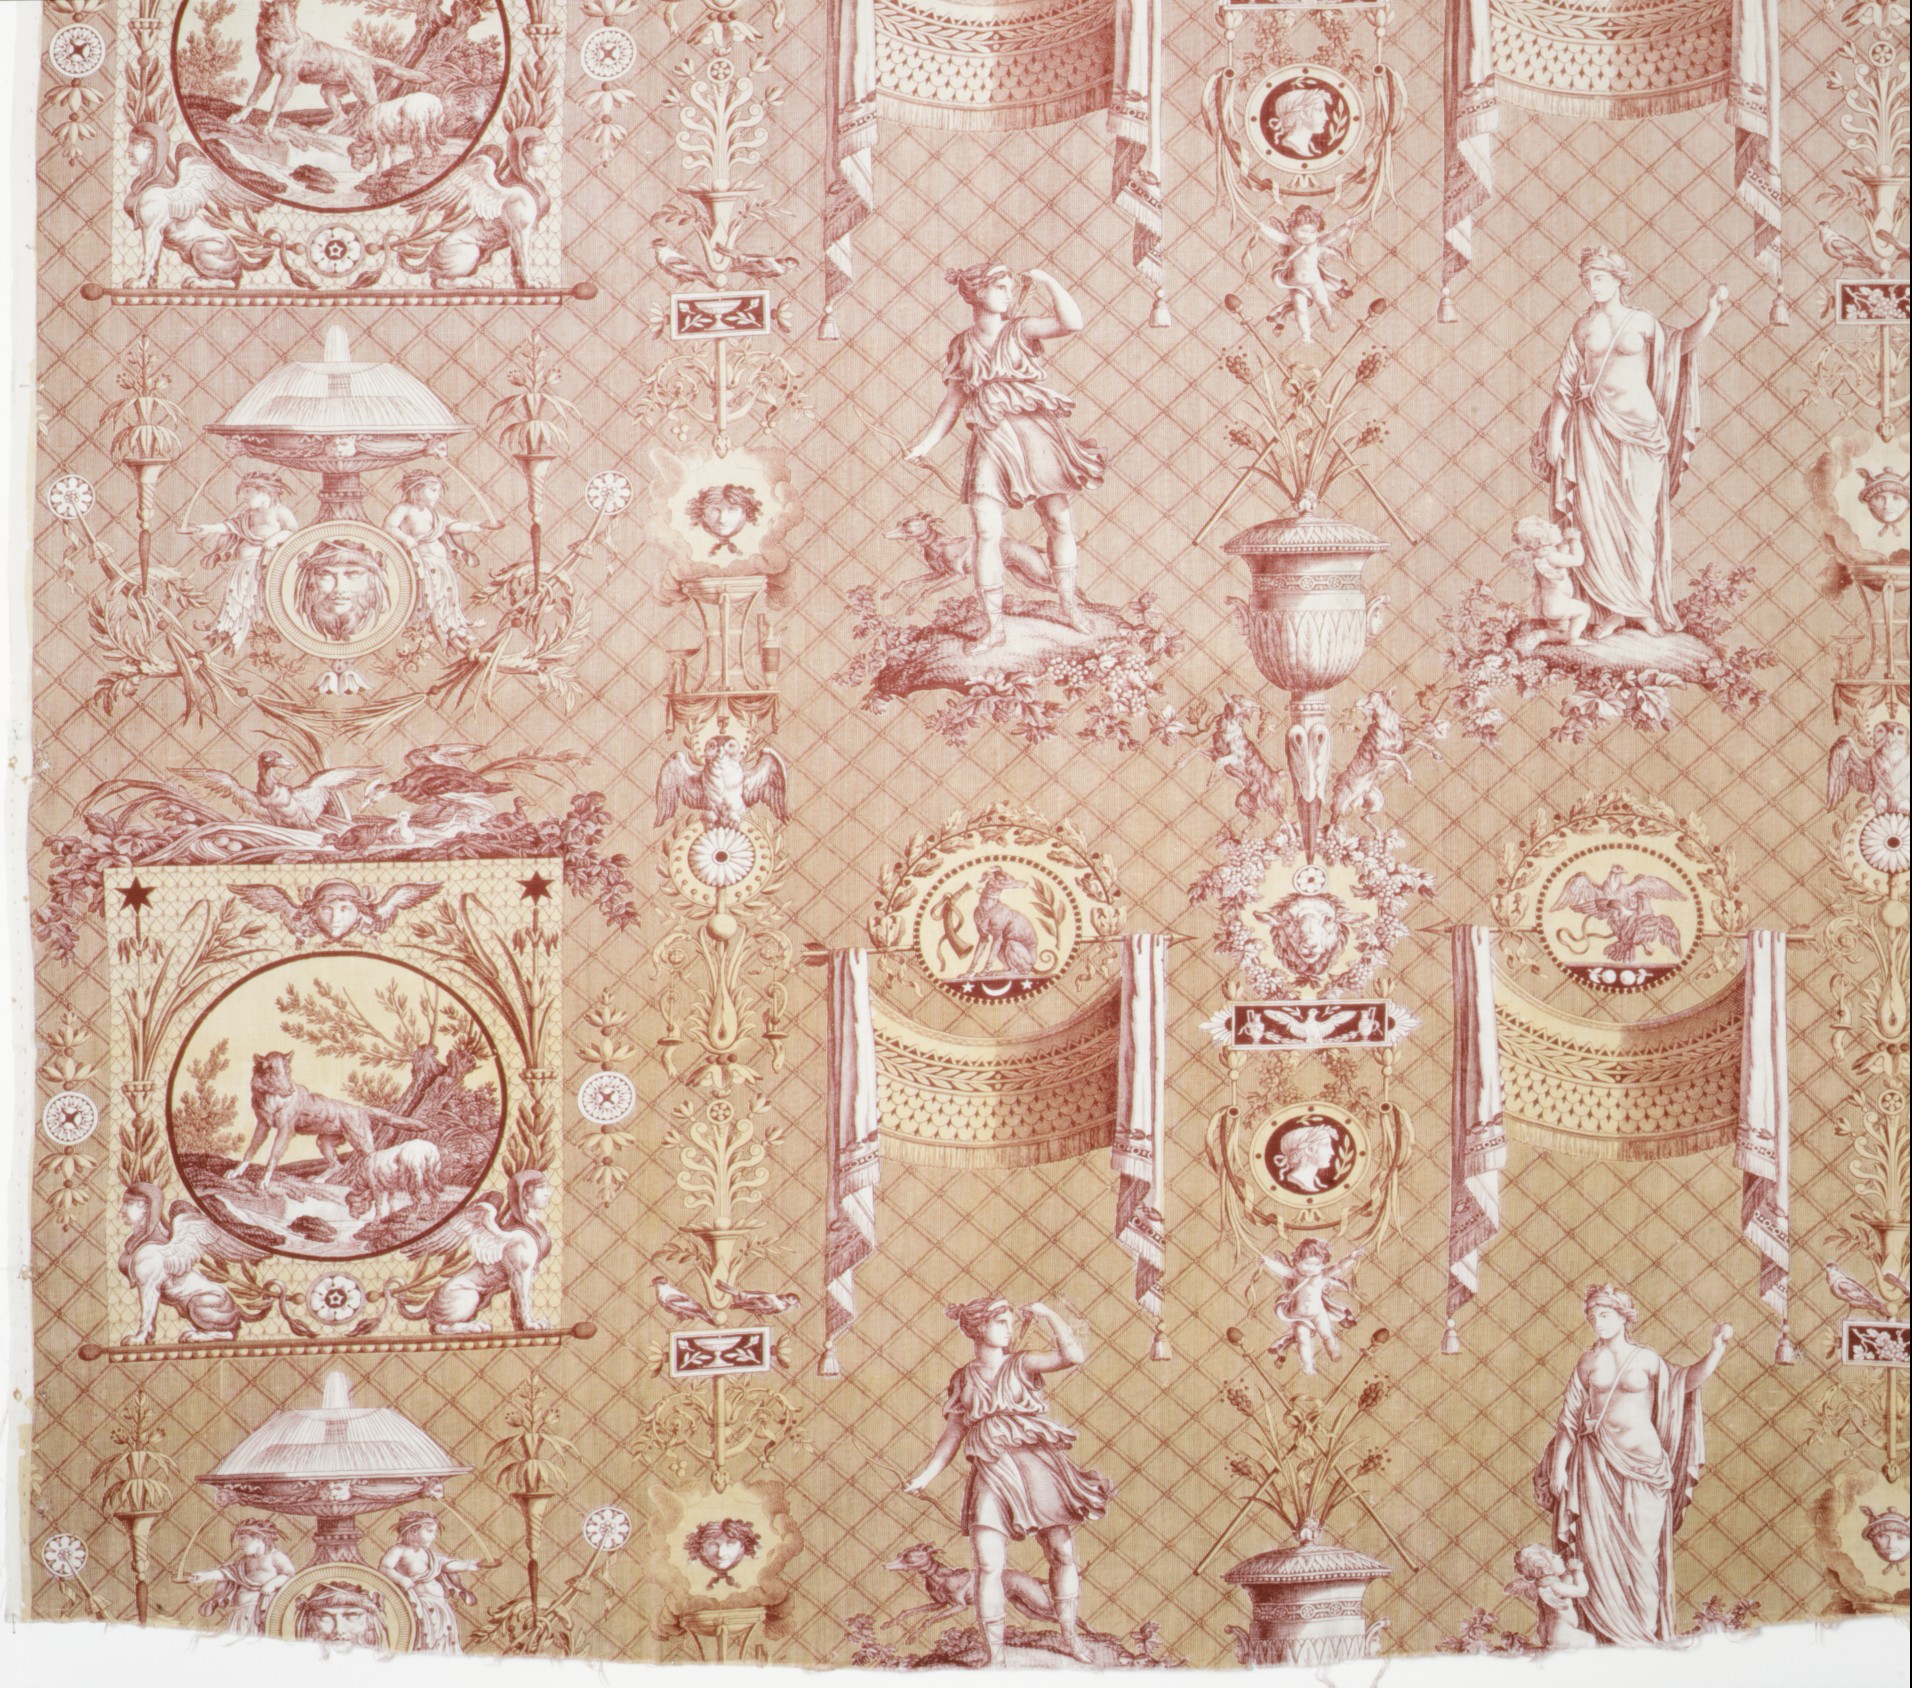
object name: furnishing textile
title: The Wolf and the Lamb (La Fontaine fable)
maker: jean-baptiste huet i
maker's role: designer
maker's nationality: french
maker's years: 1745-1811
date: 1804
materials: cotton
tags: human figures,animals,birds,lambs